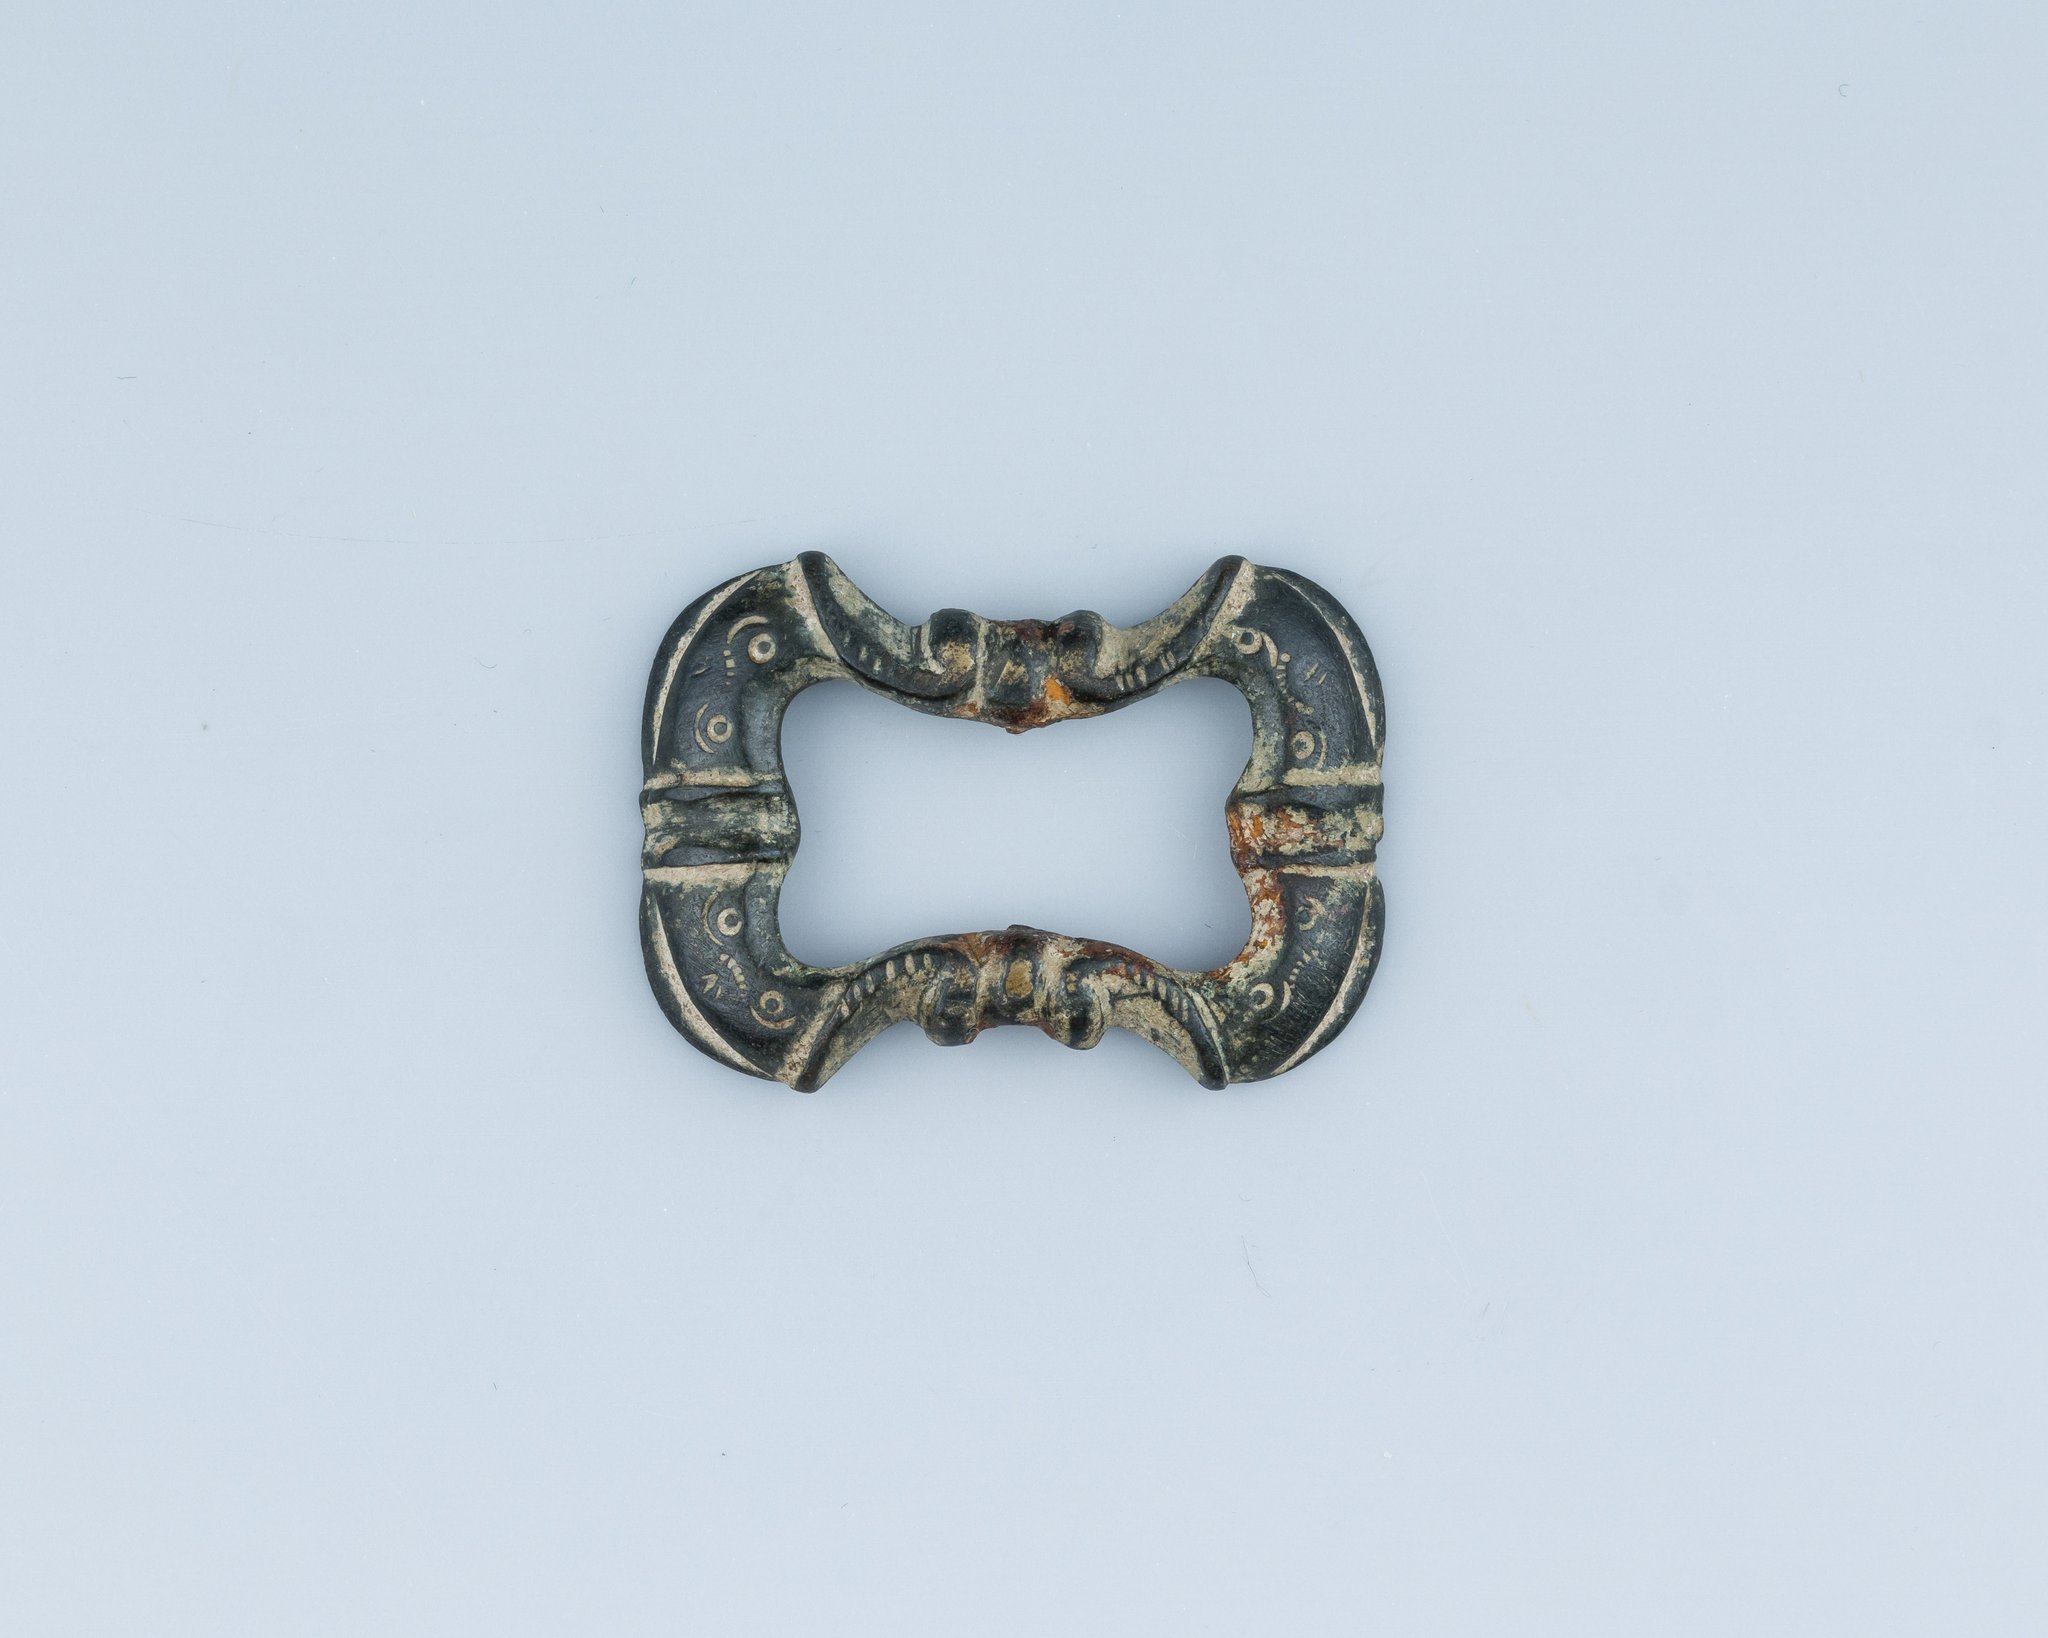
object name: buckle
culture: european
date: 1401-1600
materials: brass